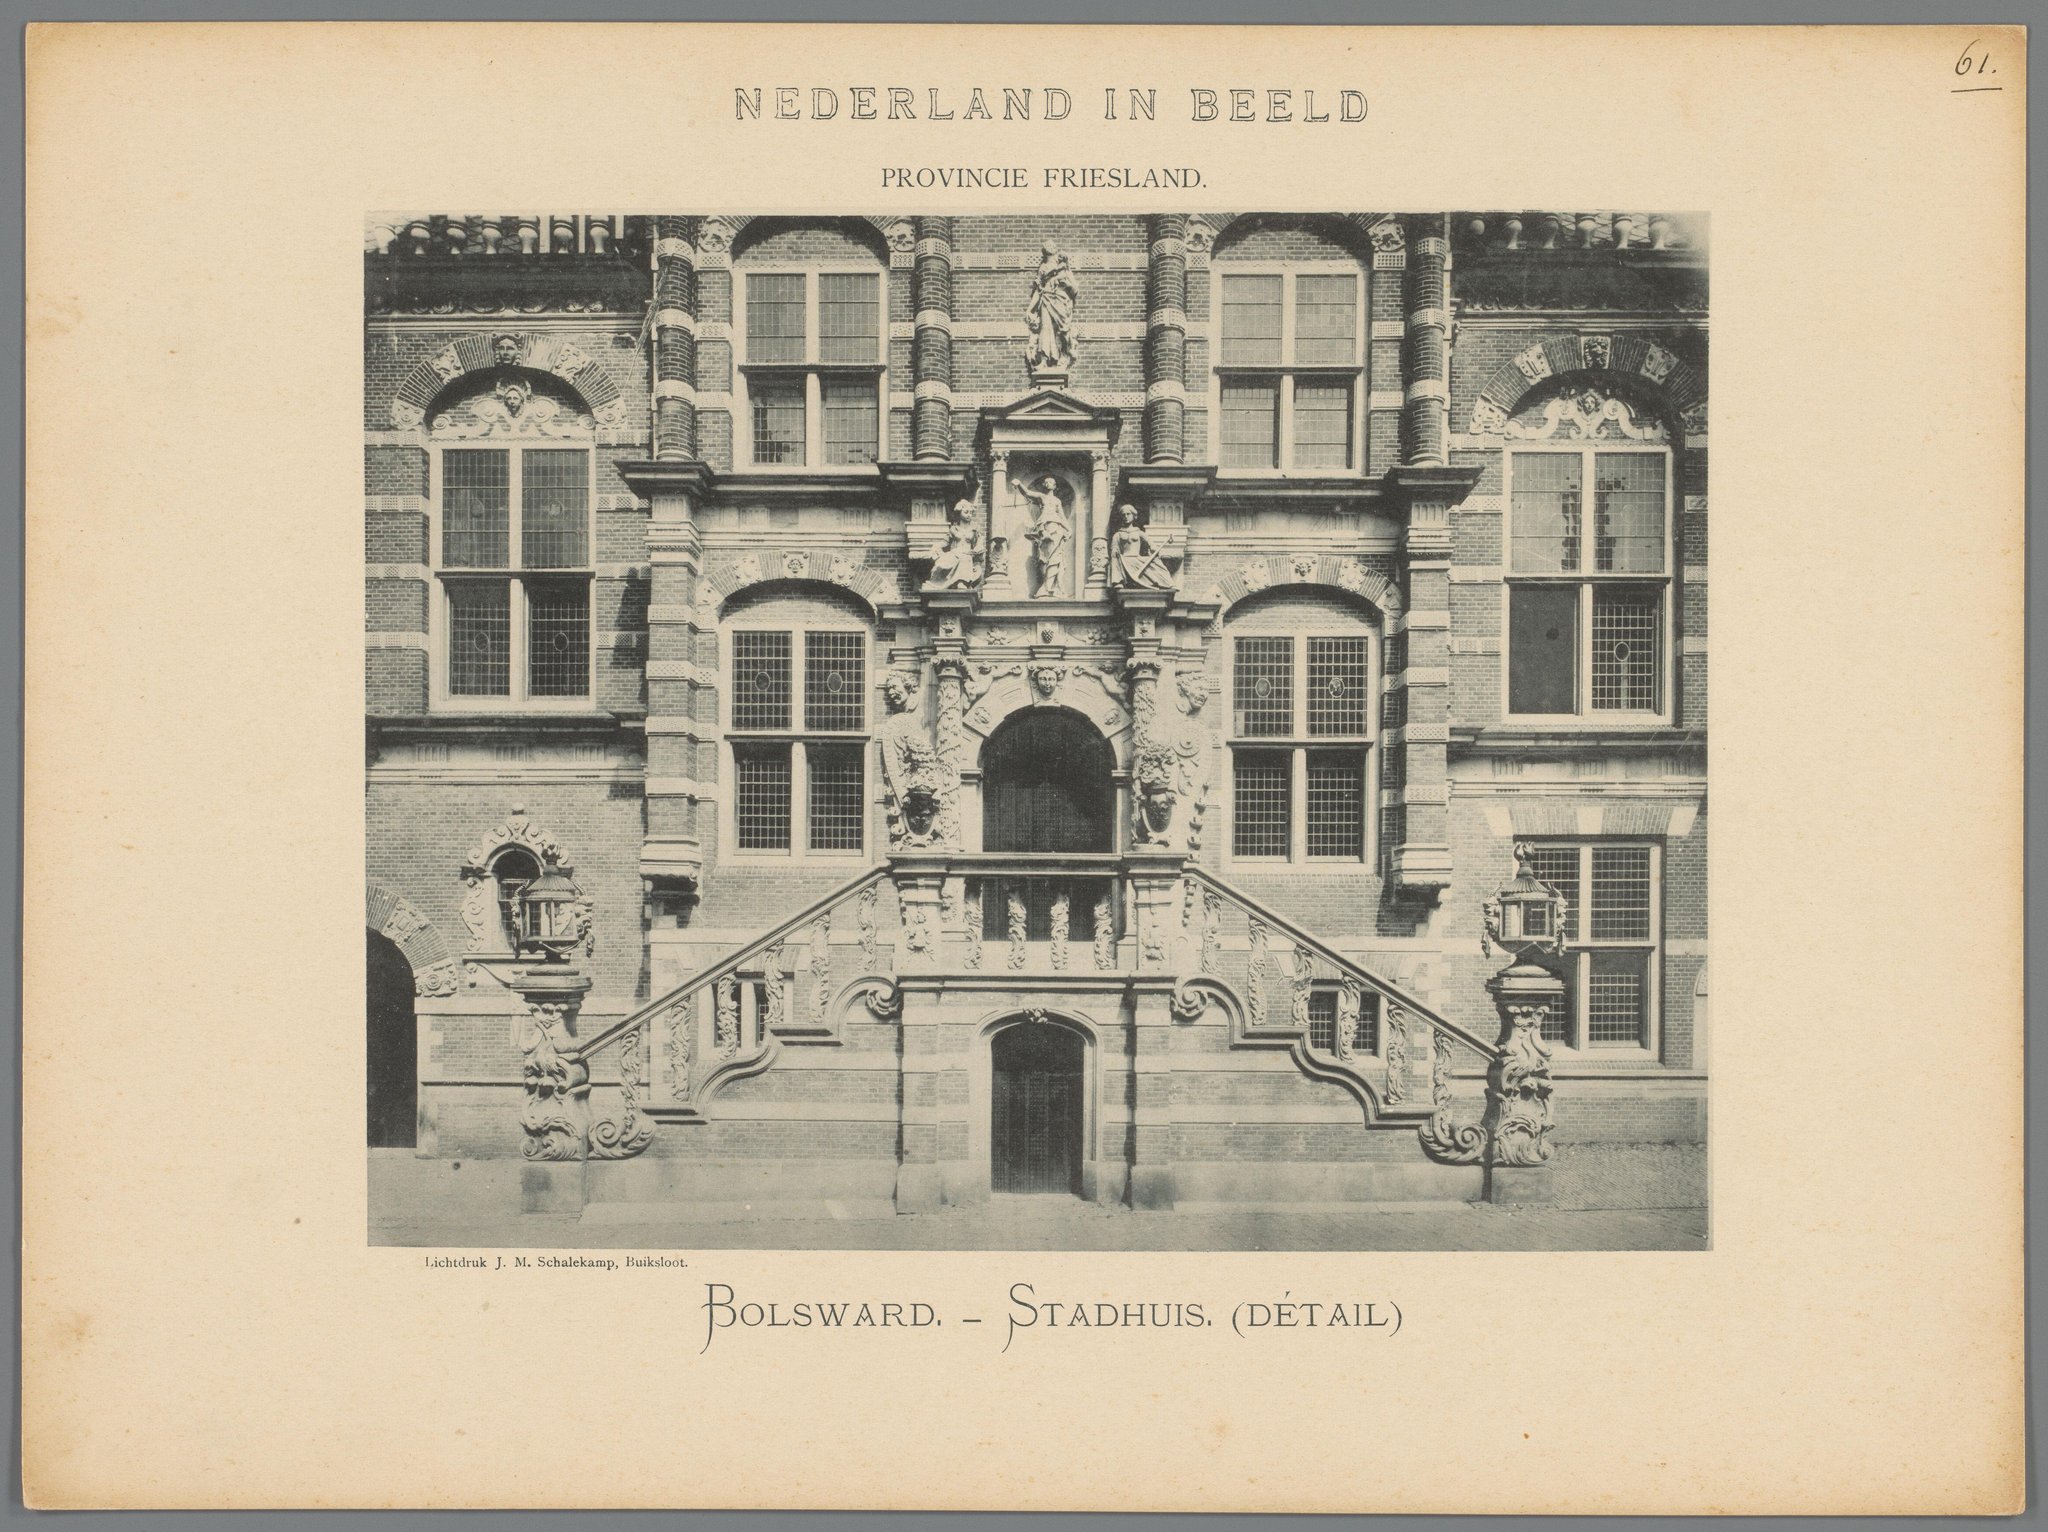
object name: photomechanical print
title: Bolsward. Stadhuis (détail)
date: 1893-1896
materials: paper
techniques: photograph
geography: buiksloot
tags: townhall, front steps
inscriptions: number: ‘61.’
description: Deze prent maakt deel uit van een omslag met 43 lichtdrukken op 43 bladen.